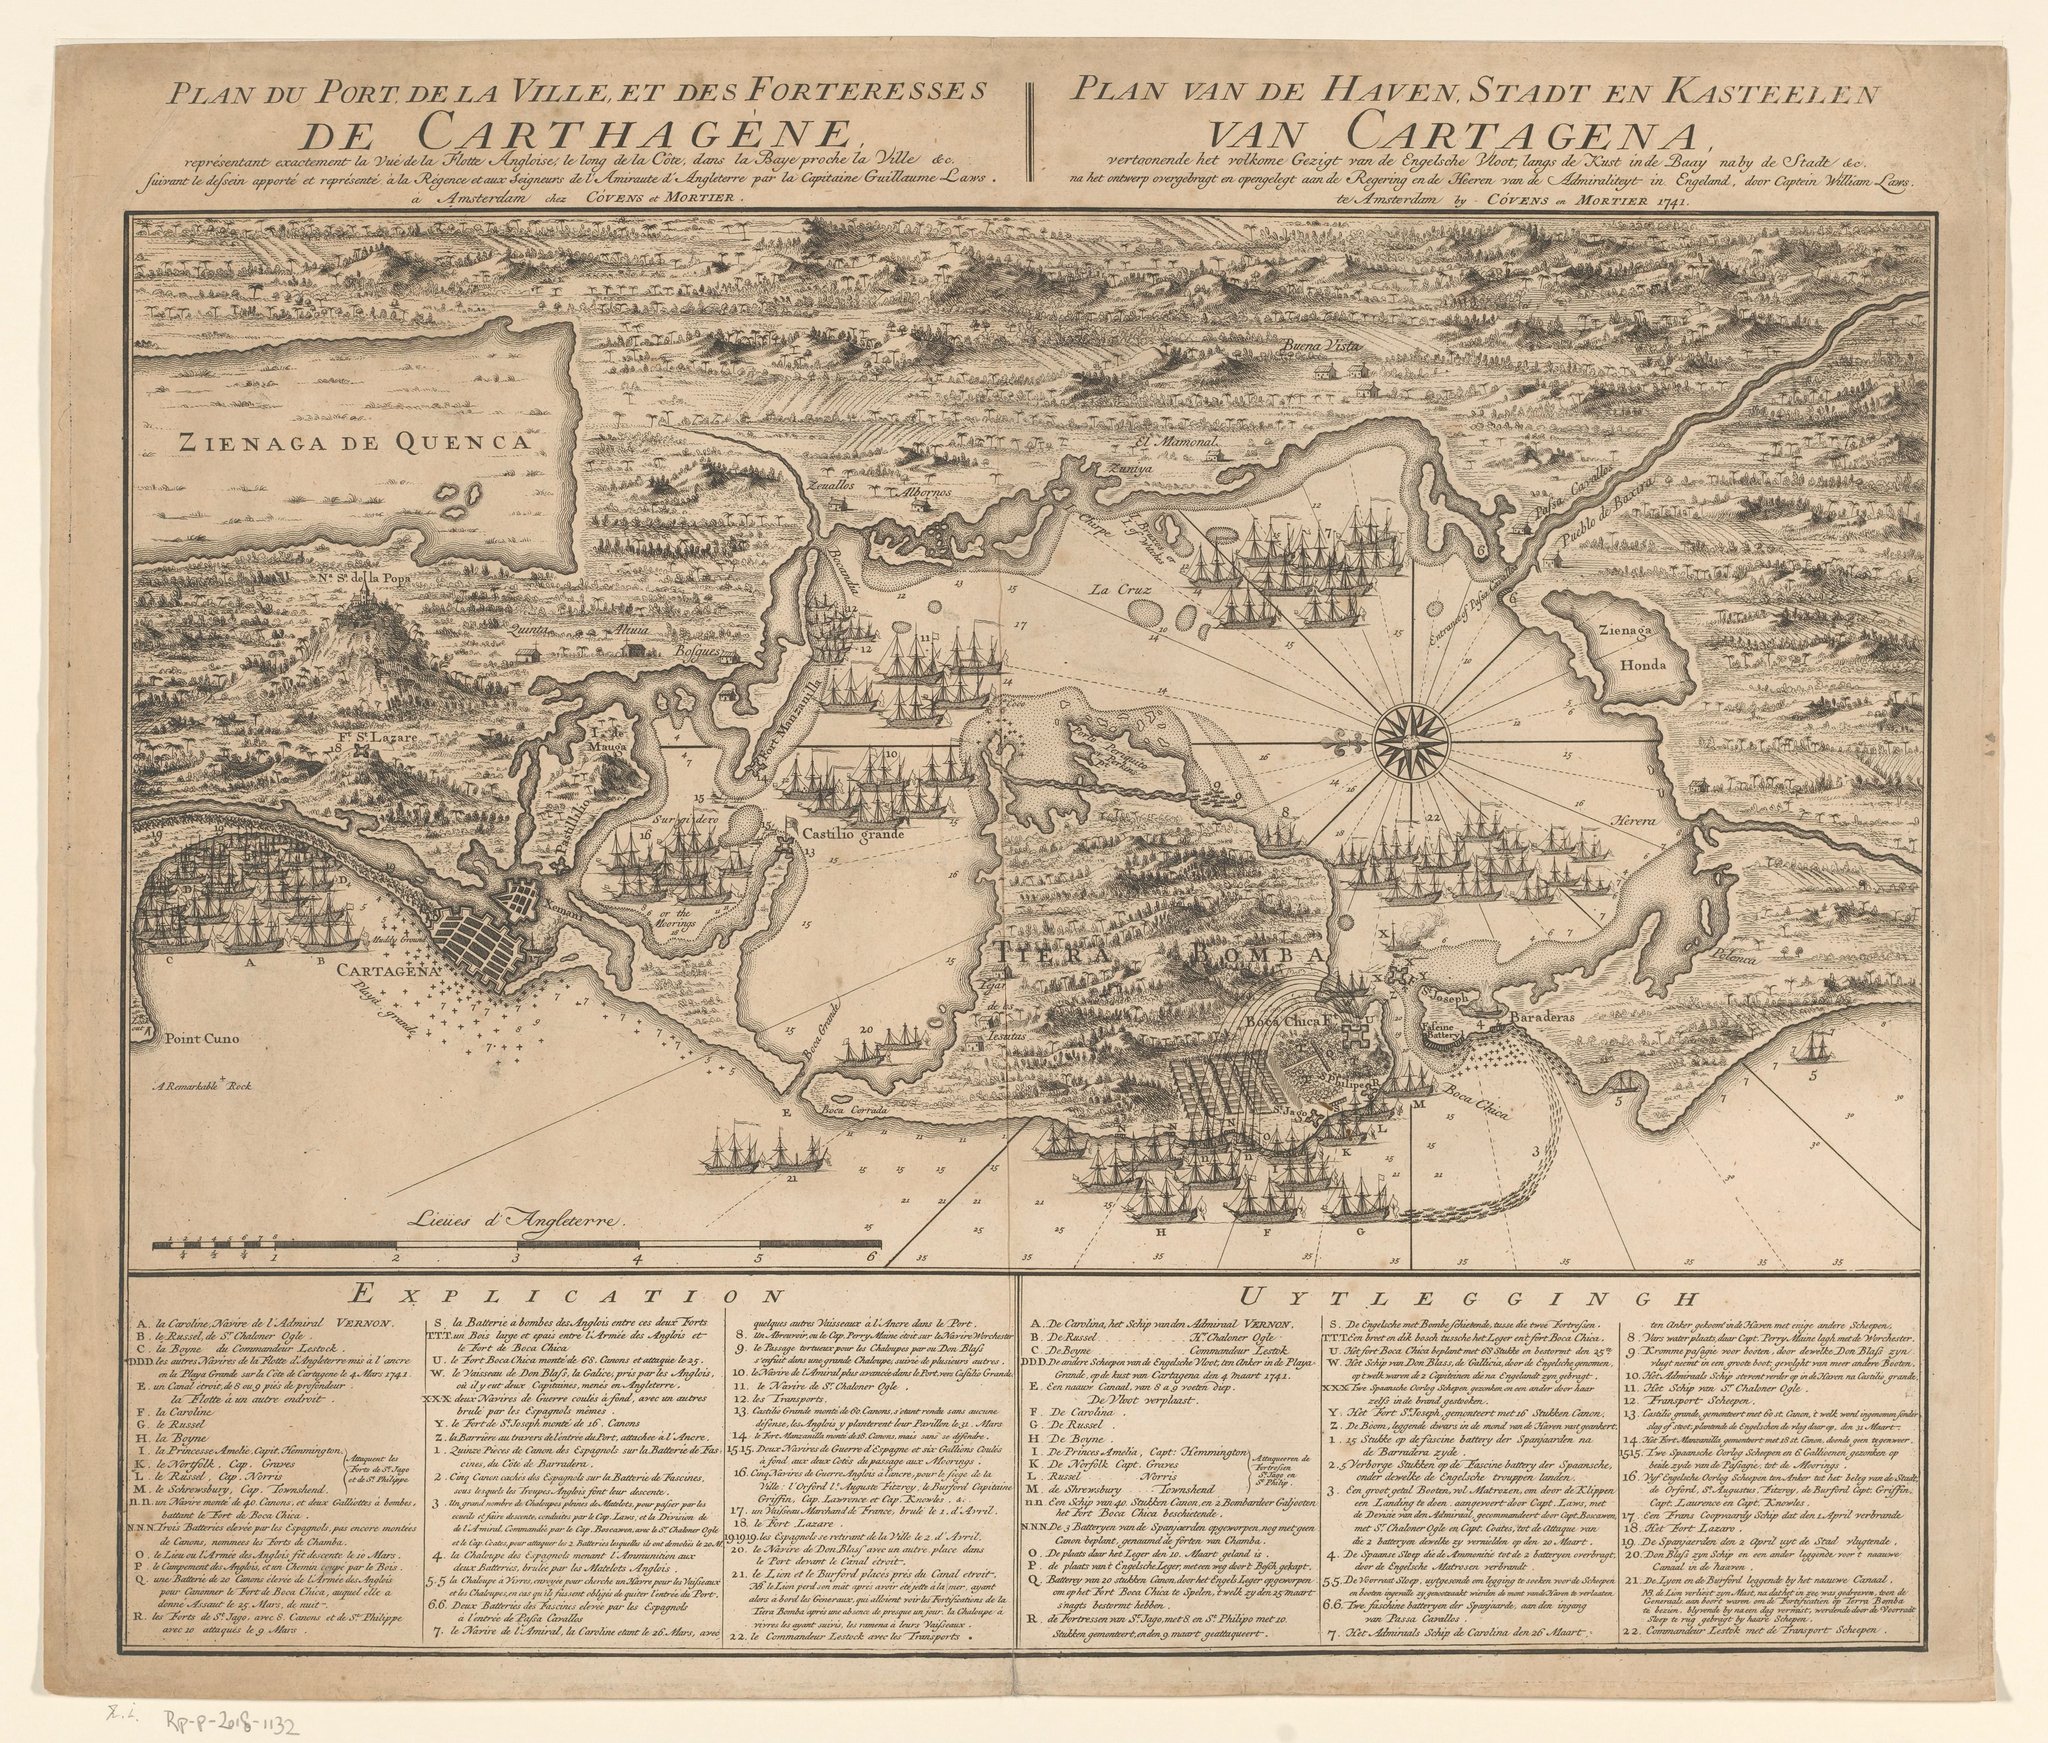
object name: print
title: Plattegrond van de omgeving van Cartagena met de slag van Cartagena, 1741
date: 1741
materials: paper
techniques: engraving, etching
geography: amsterdam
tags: marine charts, battle (+ sailing-ships)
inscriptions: collector's mark: Lugt 2228